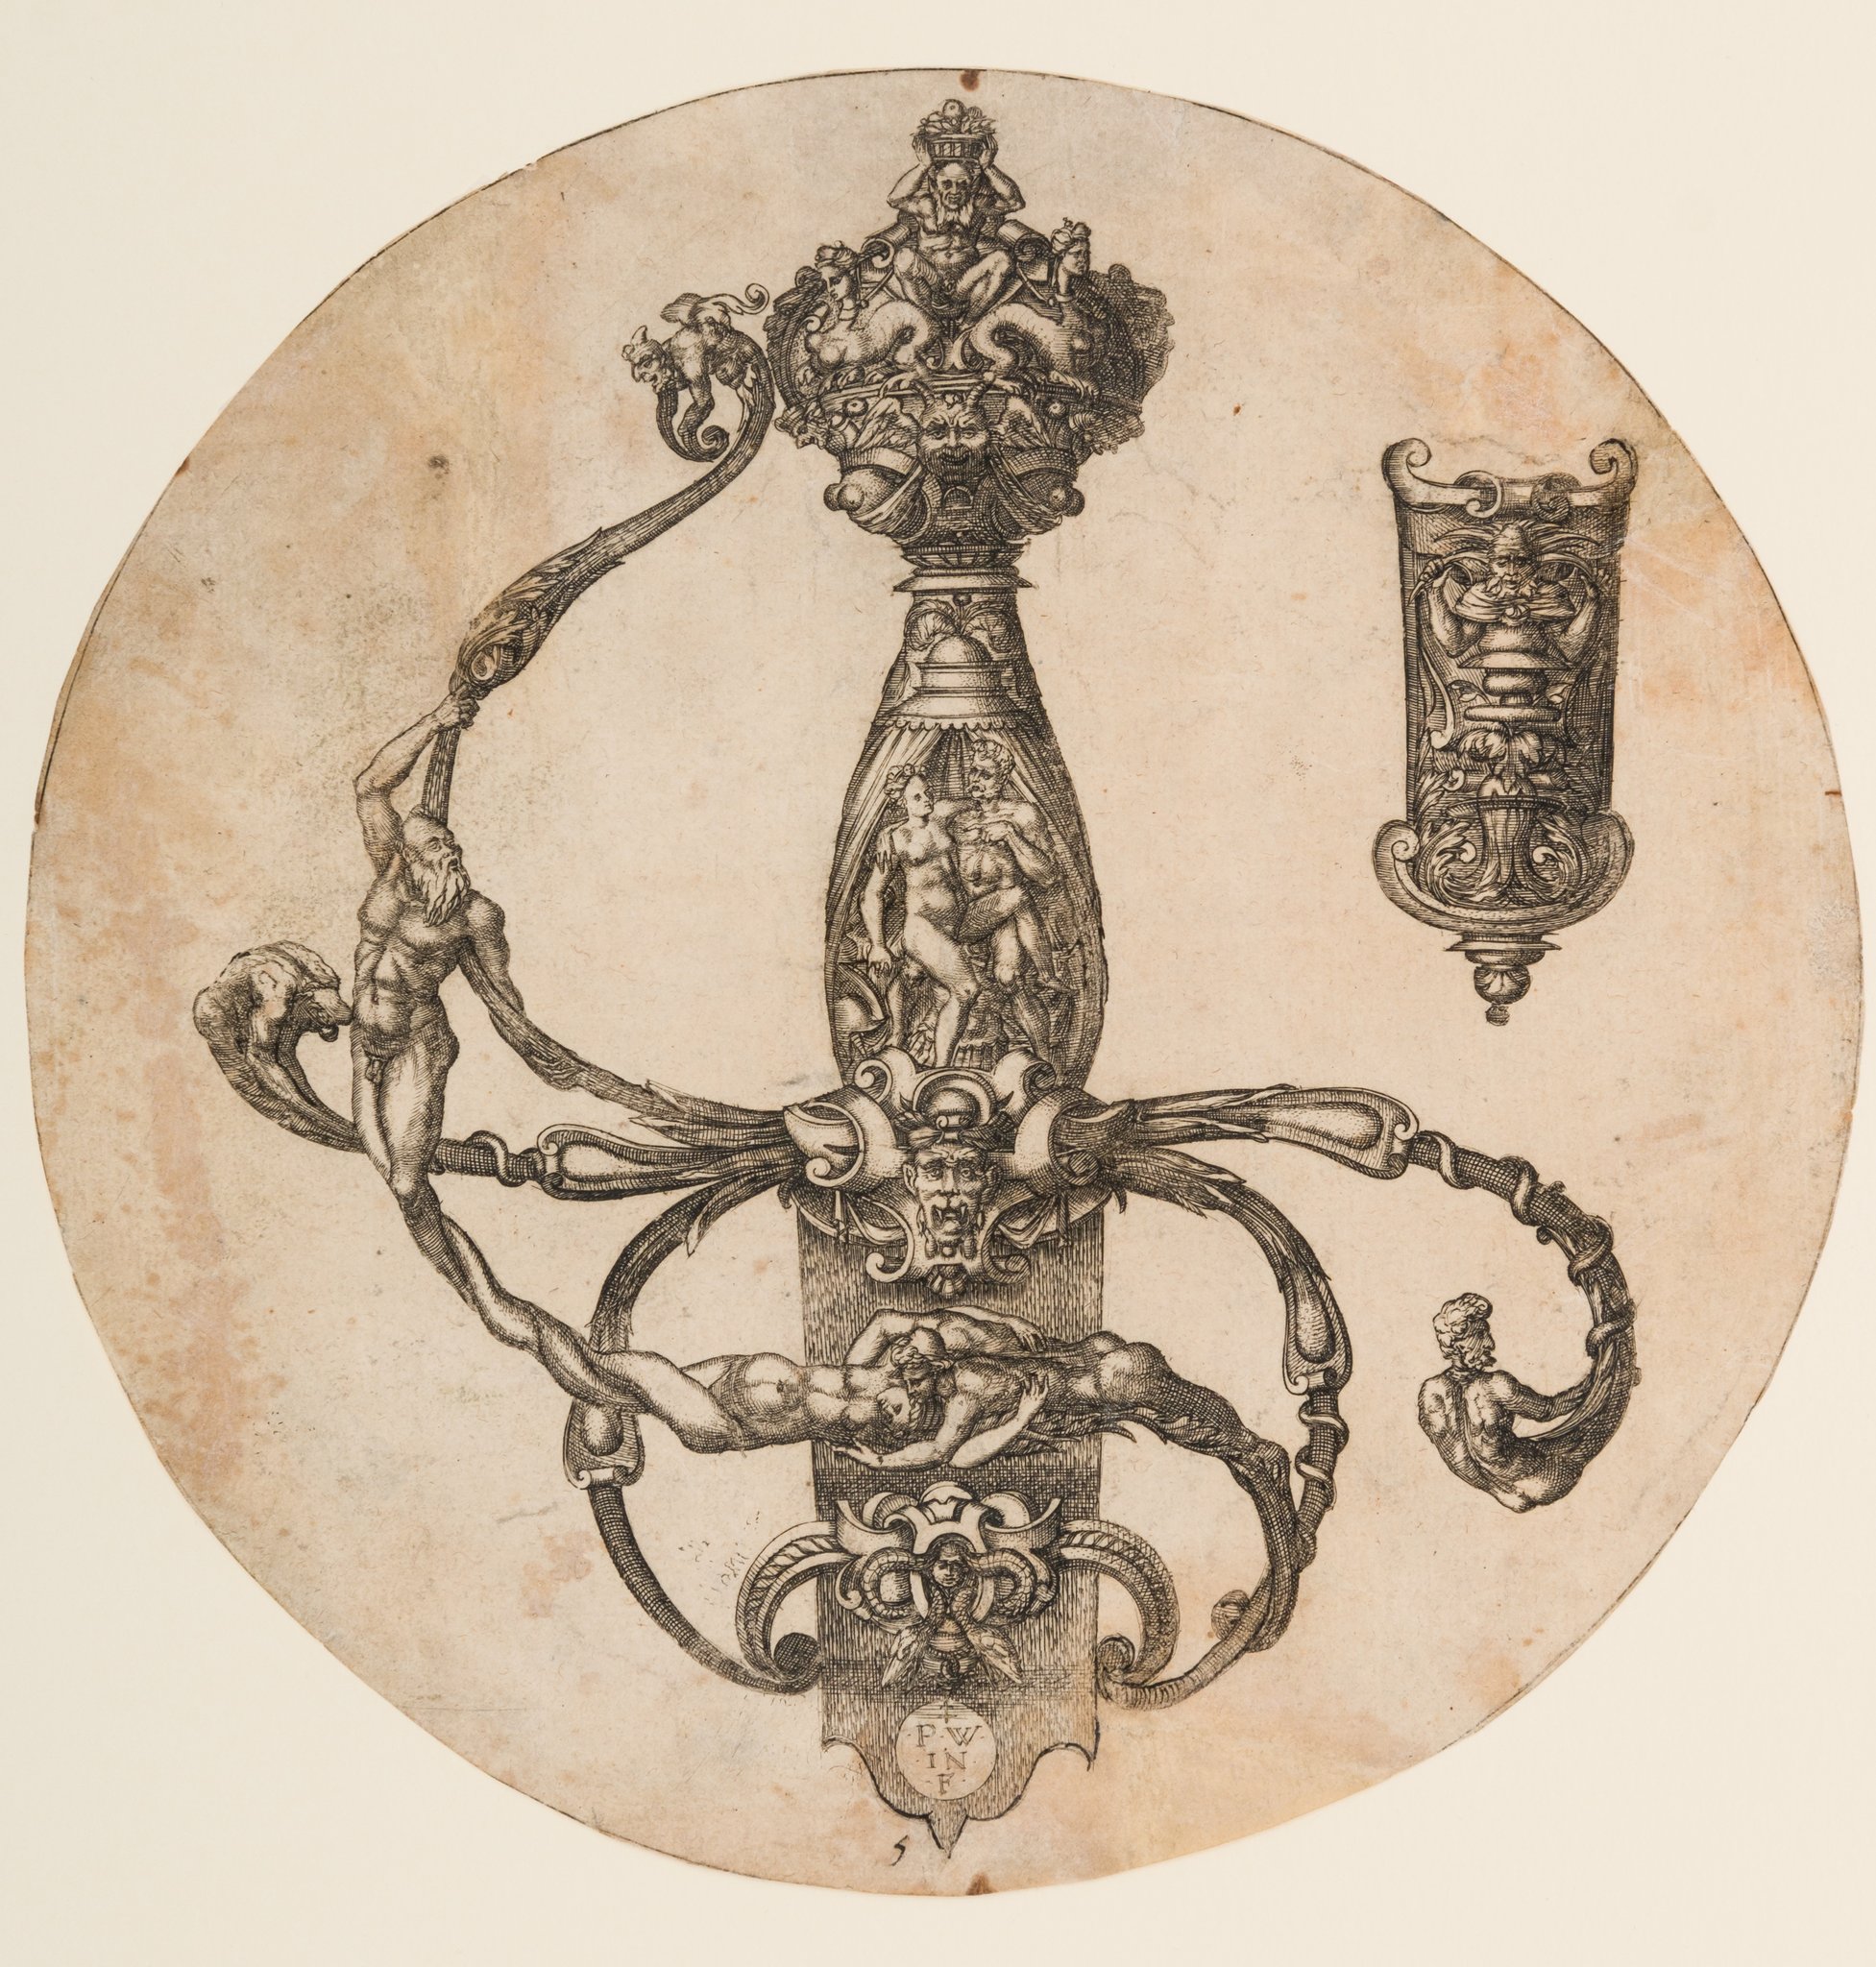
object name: etching and engraving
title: Design for a Rapier Hilt and Scabbard Chape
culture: french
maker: pierre woeiriot de bouzey ii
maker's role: artist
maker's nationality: french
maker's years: 1532-1599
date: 1555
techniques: engraving, etching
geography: france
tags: hilts,ornament